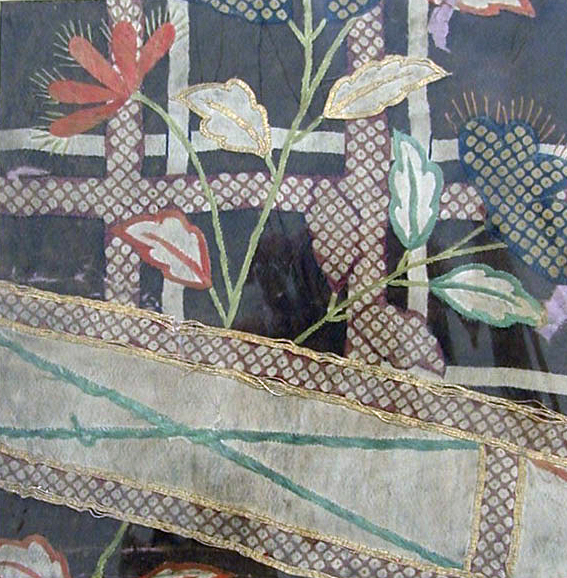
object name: piece from a kosode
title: Piece from a Kosode with Fence and Autumn Flowers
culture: japanese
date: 1615-1868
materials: metal thread, silk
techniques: dyeing, embroidery, weave, resist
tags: flowers,leaves